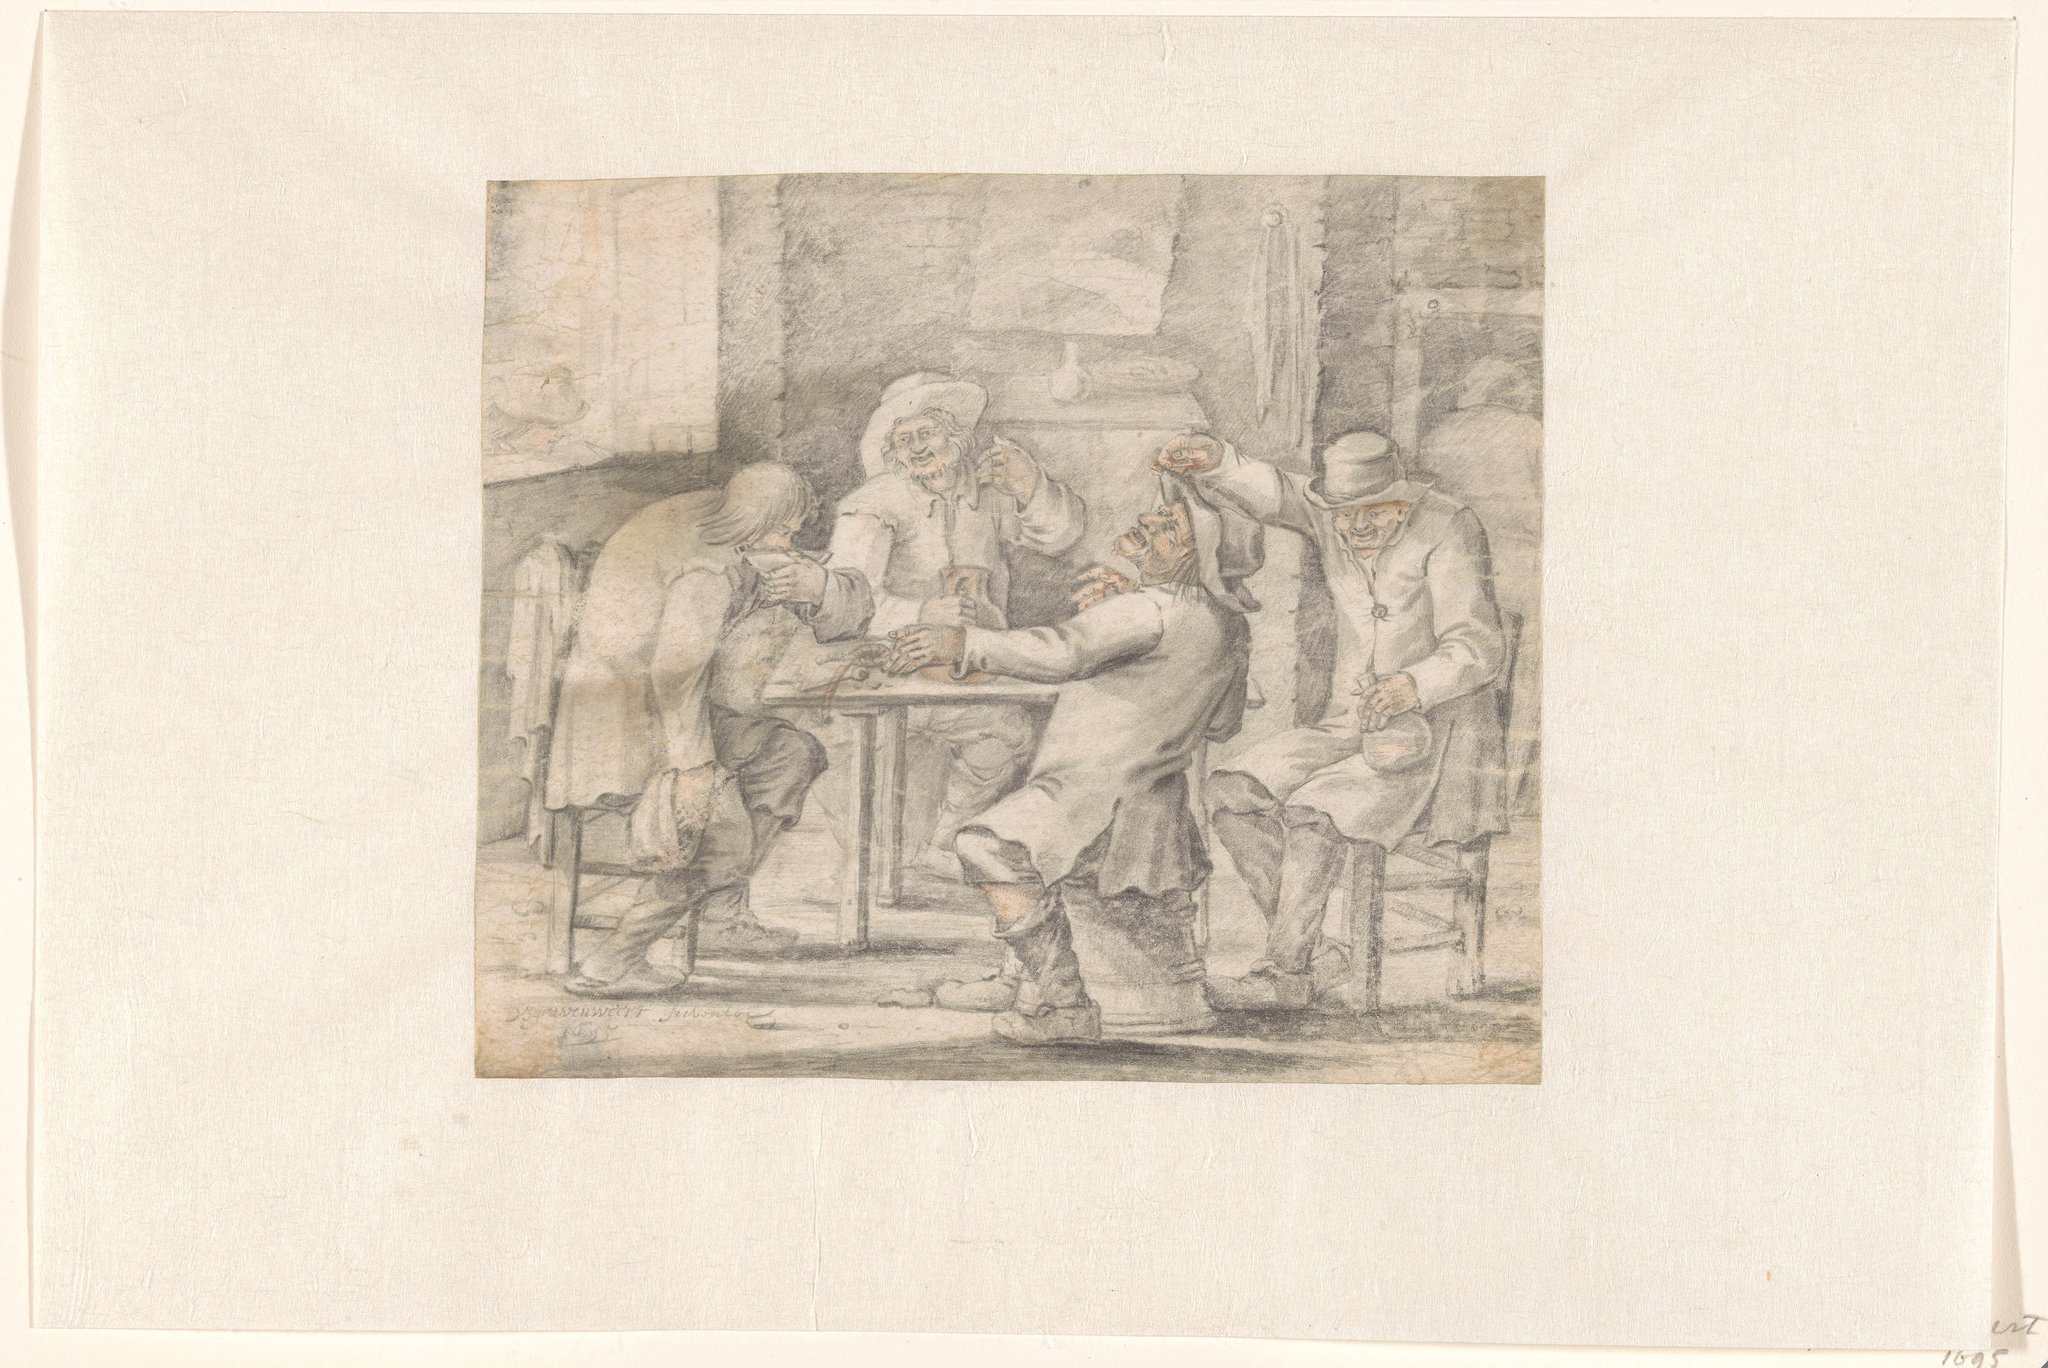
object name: drawing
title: Gezelschap drinkende boeren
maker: d. van s gravenweert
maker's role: draughtsman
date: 1695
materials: chalk, parchment, pencil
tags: inn, coffee-house, public house, etc., farmers, drunken brawl (usually peasants fighting in an inn)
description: Pendant van "Rokende en drinkende boeren", inv. nr. RP-T-1954-147.